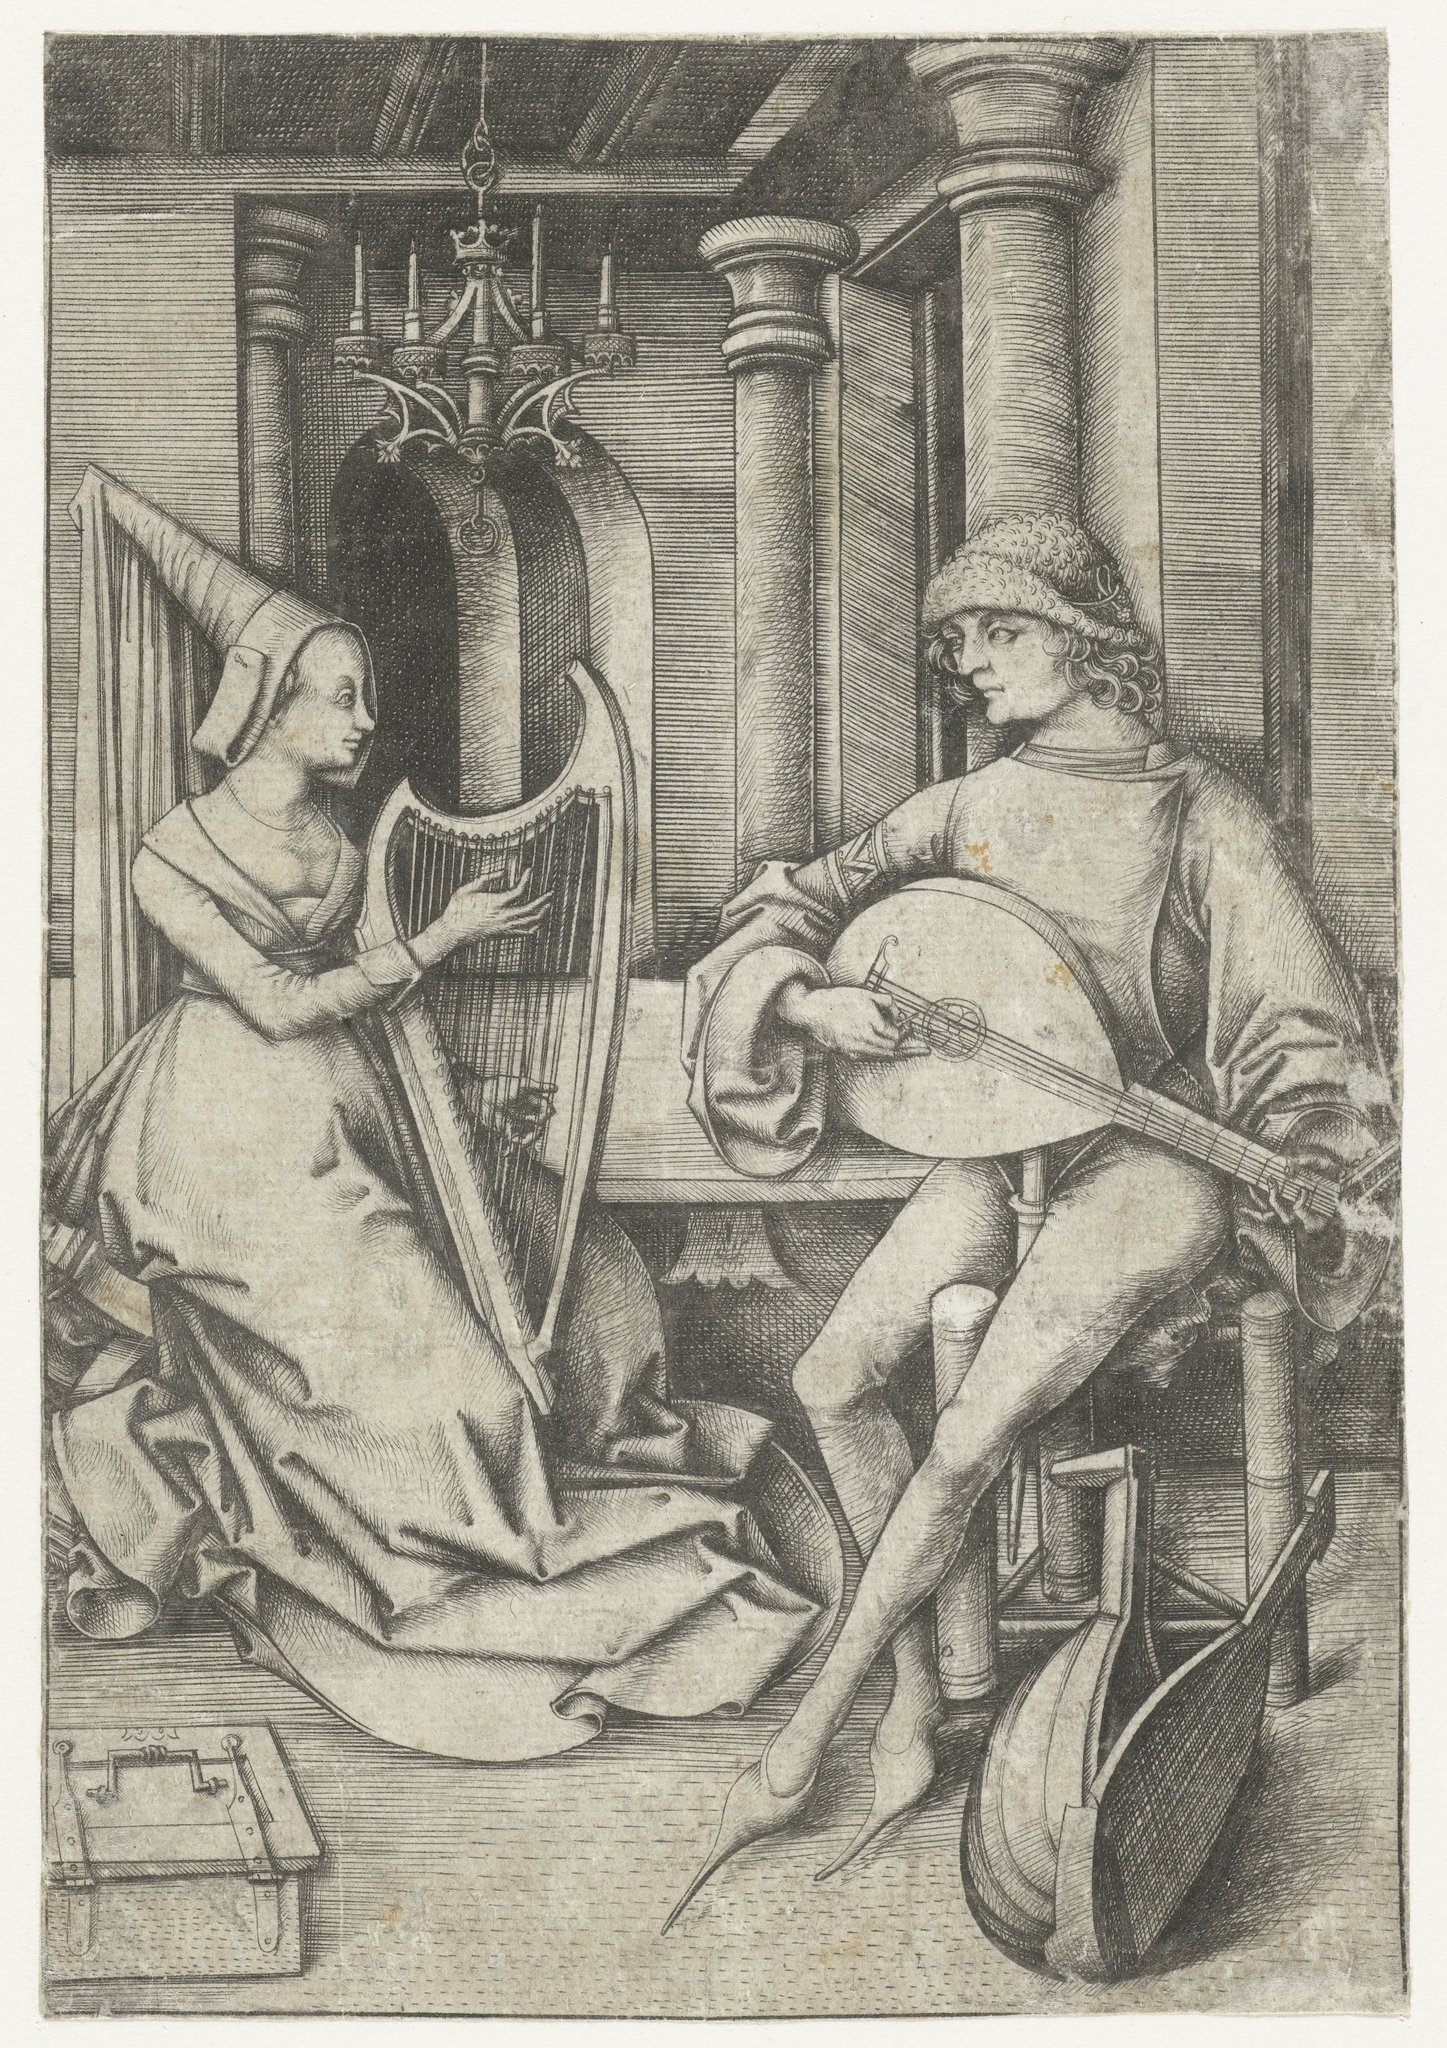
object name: print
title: De luitspeler en de harpspeelster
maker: israhel van meckenem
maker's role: print maker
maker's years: 1440-1517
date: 1475-1503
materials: paper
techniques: engraving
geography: bocholt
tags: head-gear (with name), head-gear: cap (+ men's clothes), harp, shoes, sandals, lute, and special forms of lute, e.g.: theorbo, couple of lovers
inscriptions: collector's mark: Lugt 240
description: Kleding man: muts met opgeslagen rand aan de voorkant; kort wambuis met wijde mouwen; beenlingen; tootschoenen. Kleding vrouw: hennin met sluier (ouderwets voor de tijd; vooral gedragen aan Bourgondische hof); overkleed met decolleté met V-vormige halskraag. Datering kleding: ca. 1475-1485.